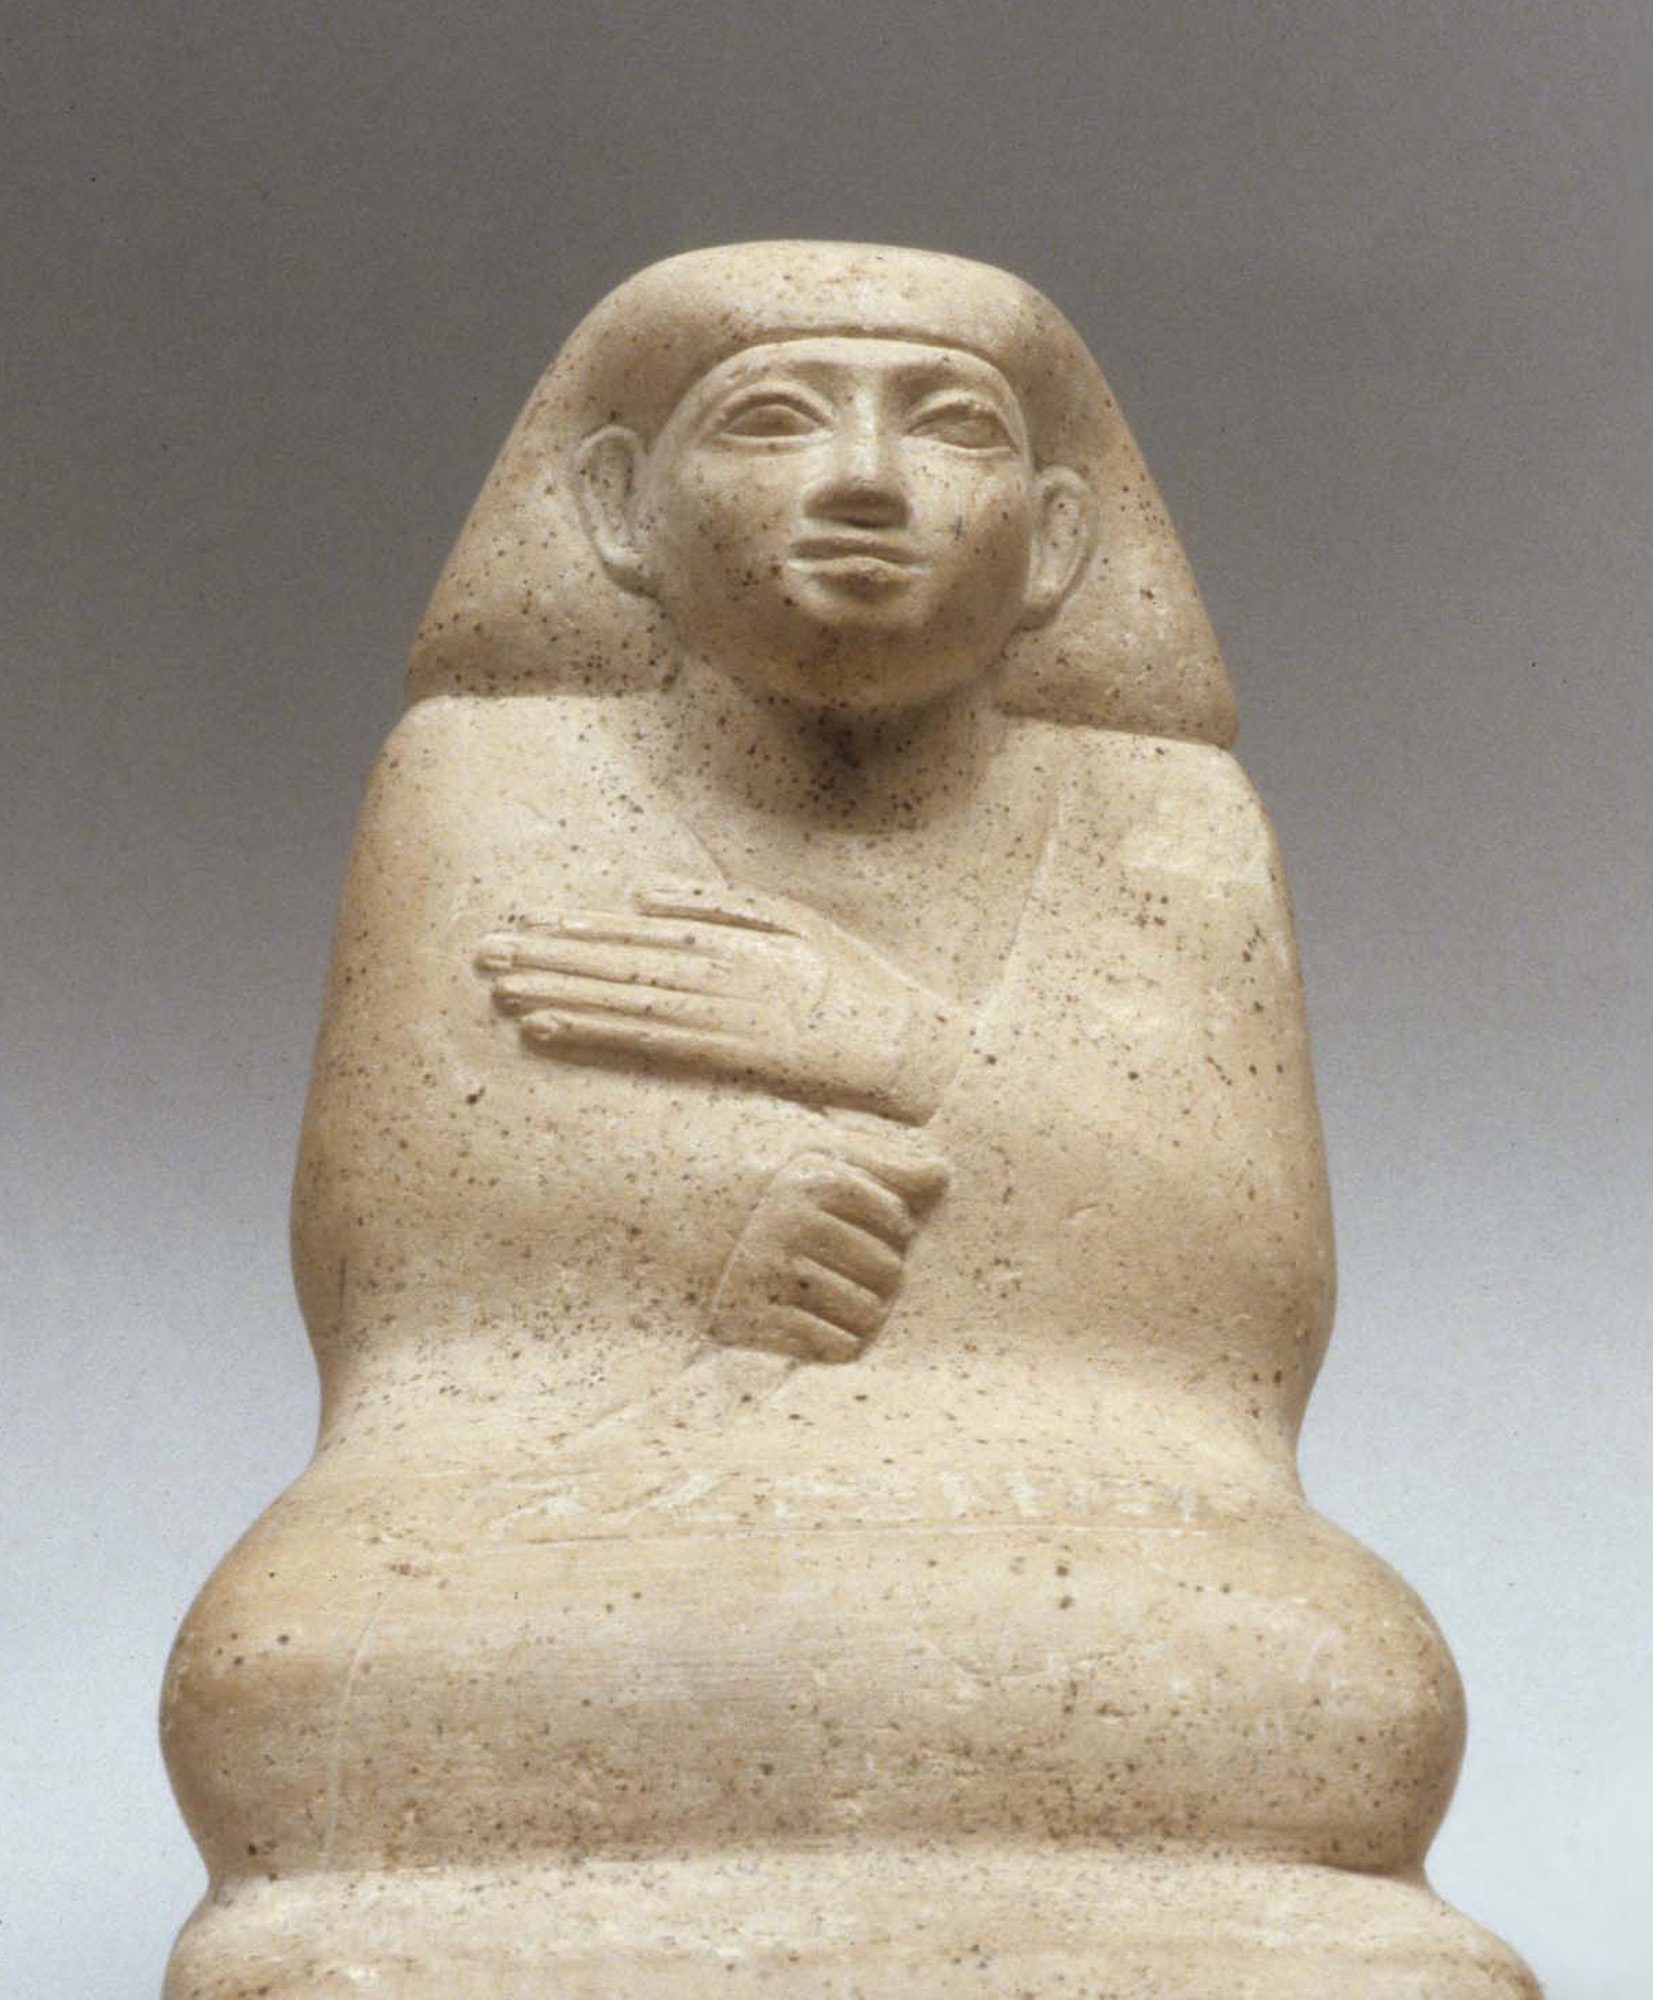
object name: statue, male squatting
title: Male squatting figure of Wekhaher (wh' Hr ?)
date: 1850-1640 BCE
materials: limestone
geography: egypt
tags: men